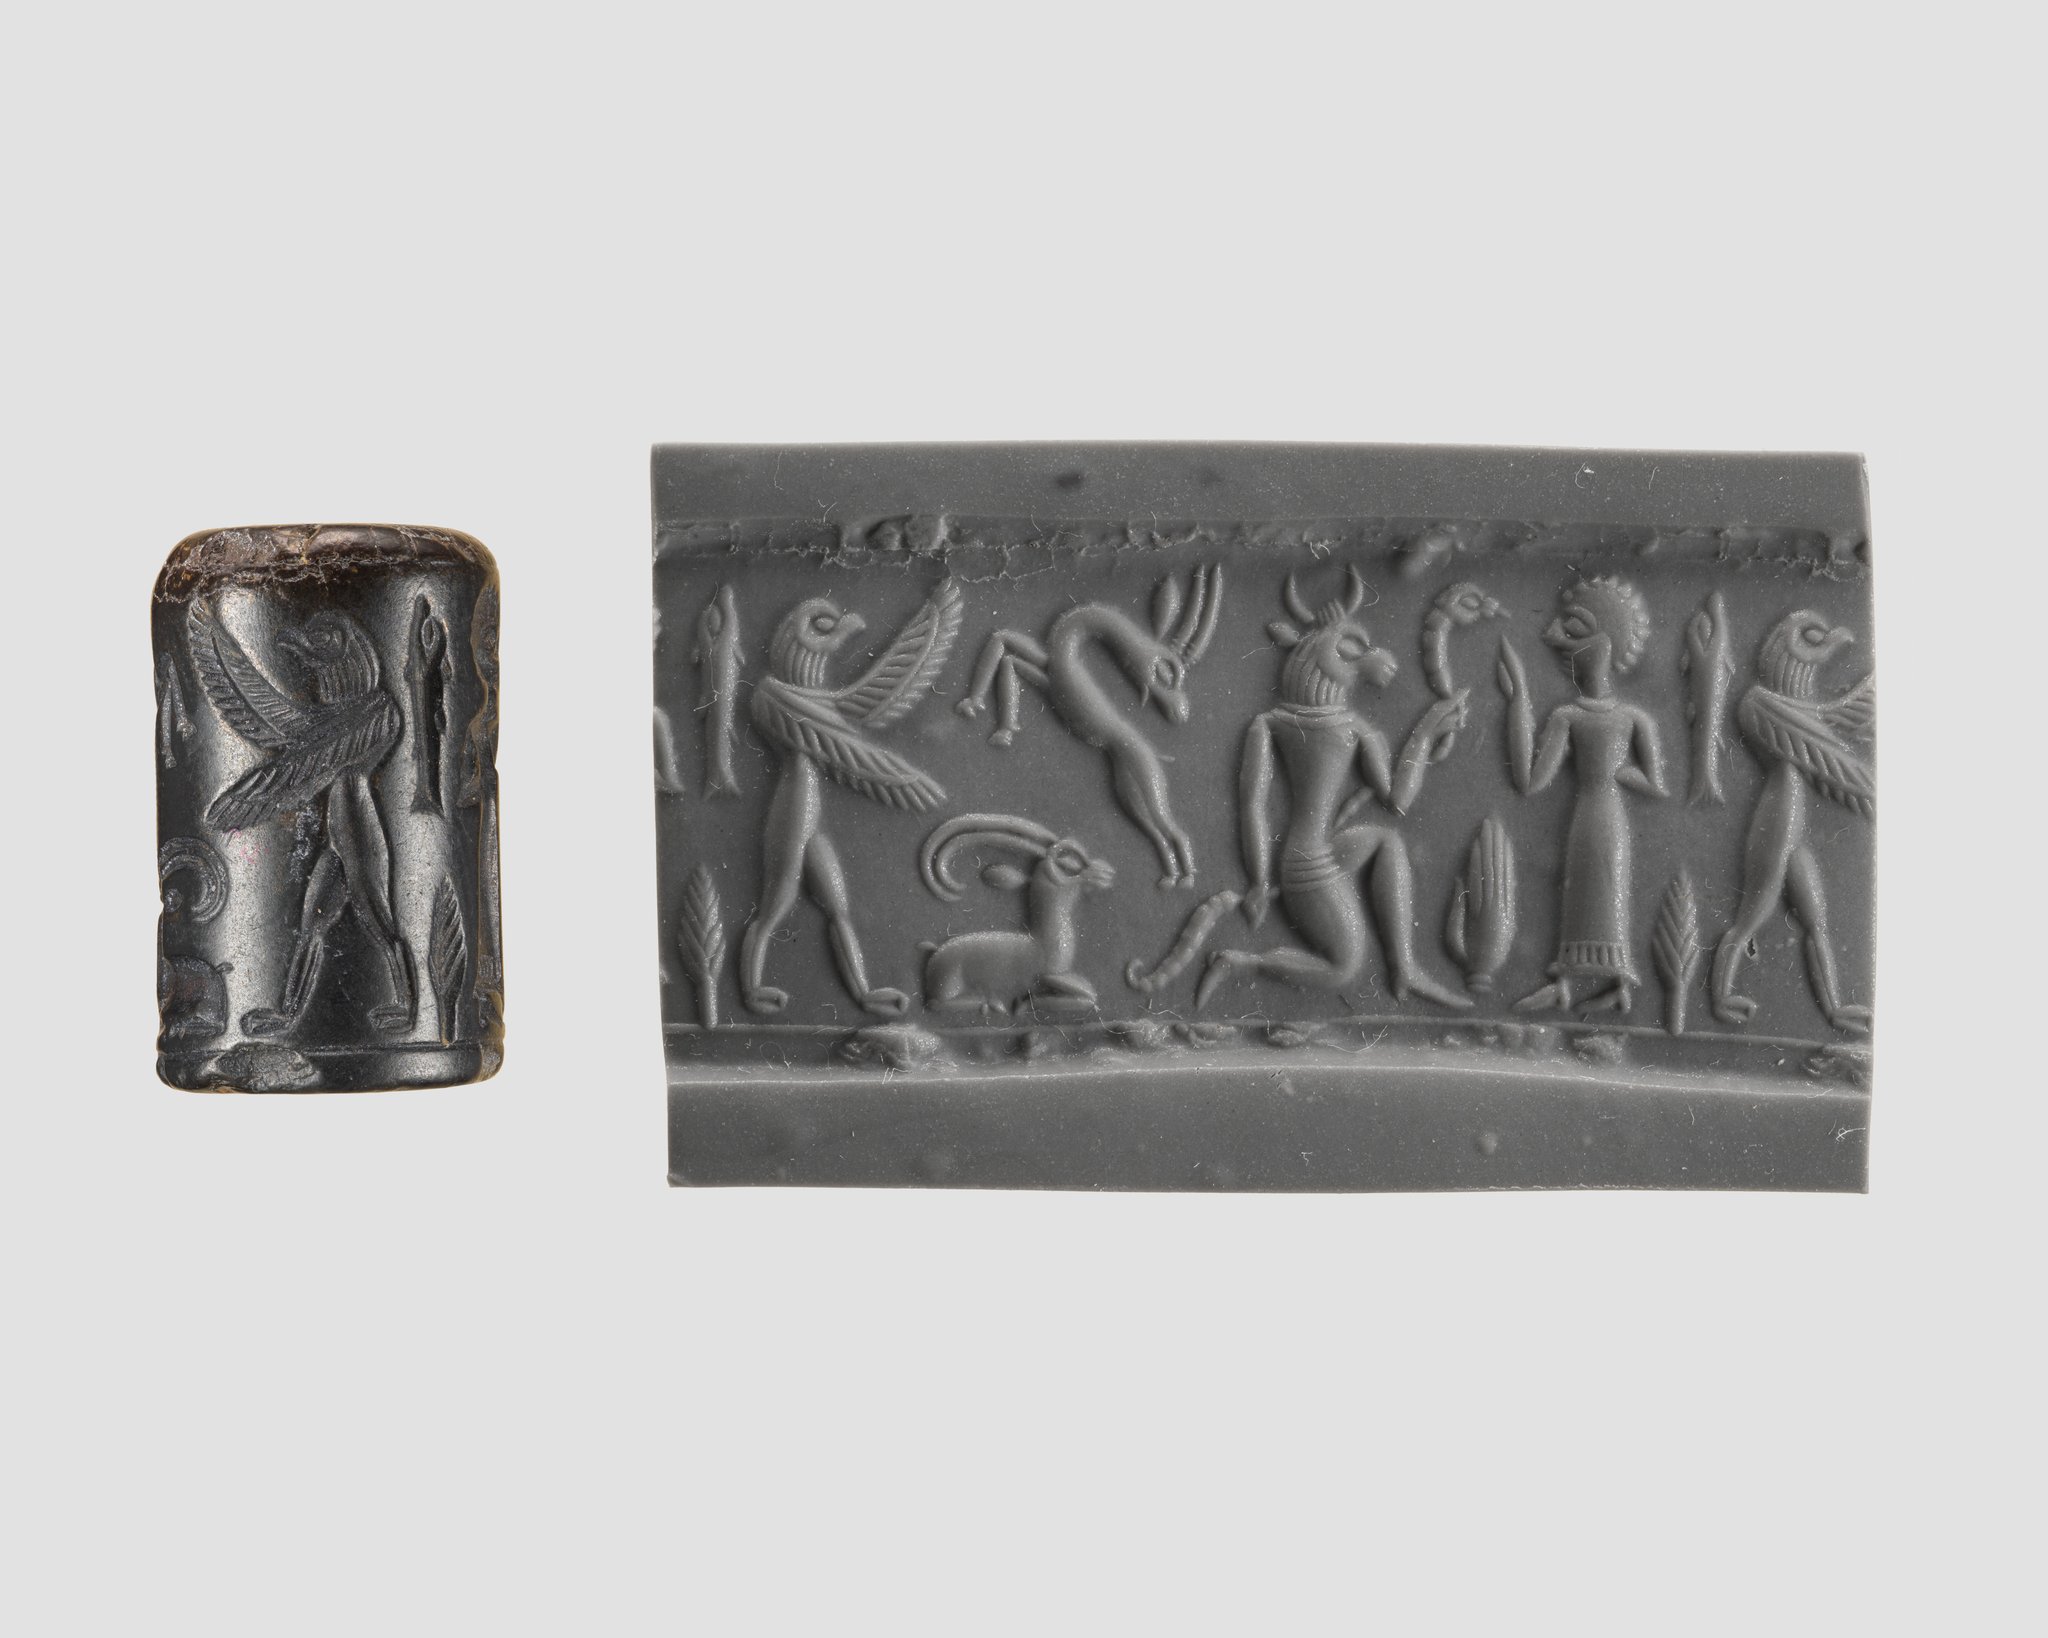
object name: cylinder seal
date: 1720-1650 BCE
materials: mineral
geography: syria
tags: animals